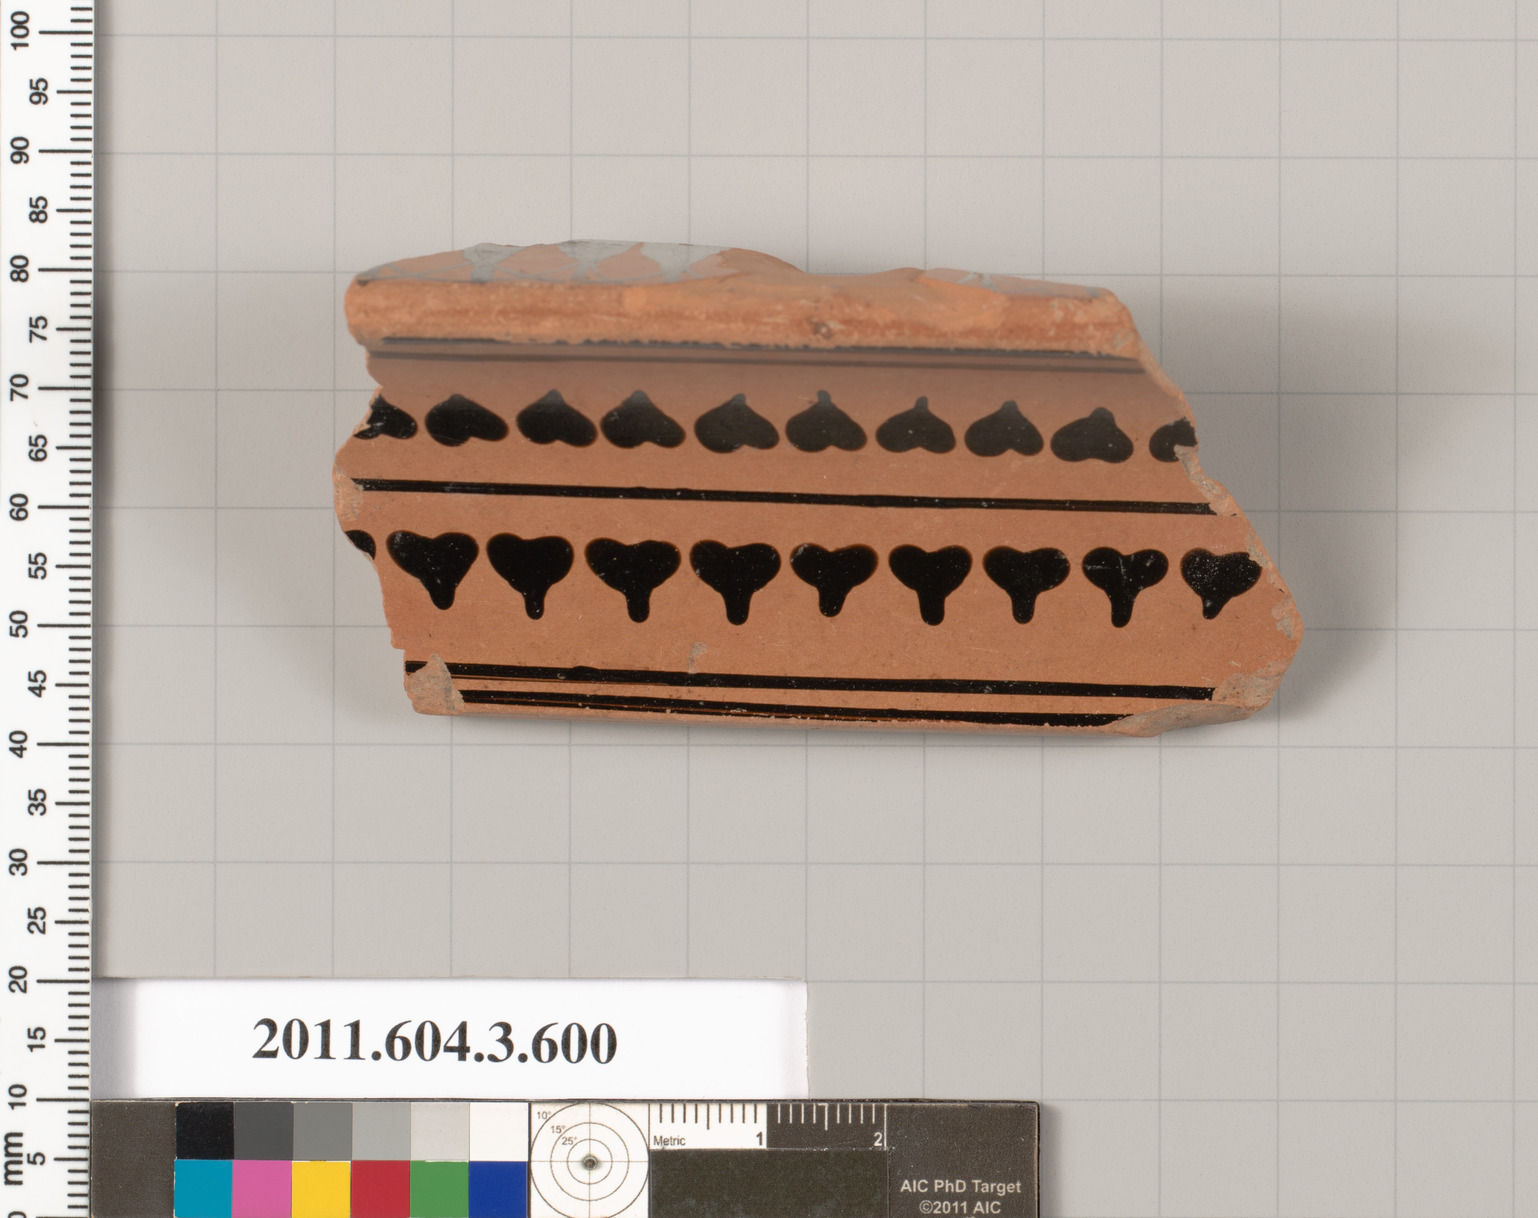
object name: column krater fragment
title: Terracotta fragment of a column-krater (bowl for mixing wine and water)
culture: greek, attic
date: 525-501 BCE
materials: terracotta